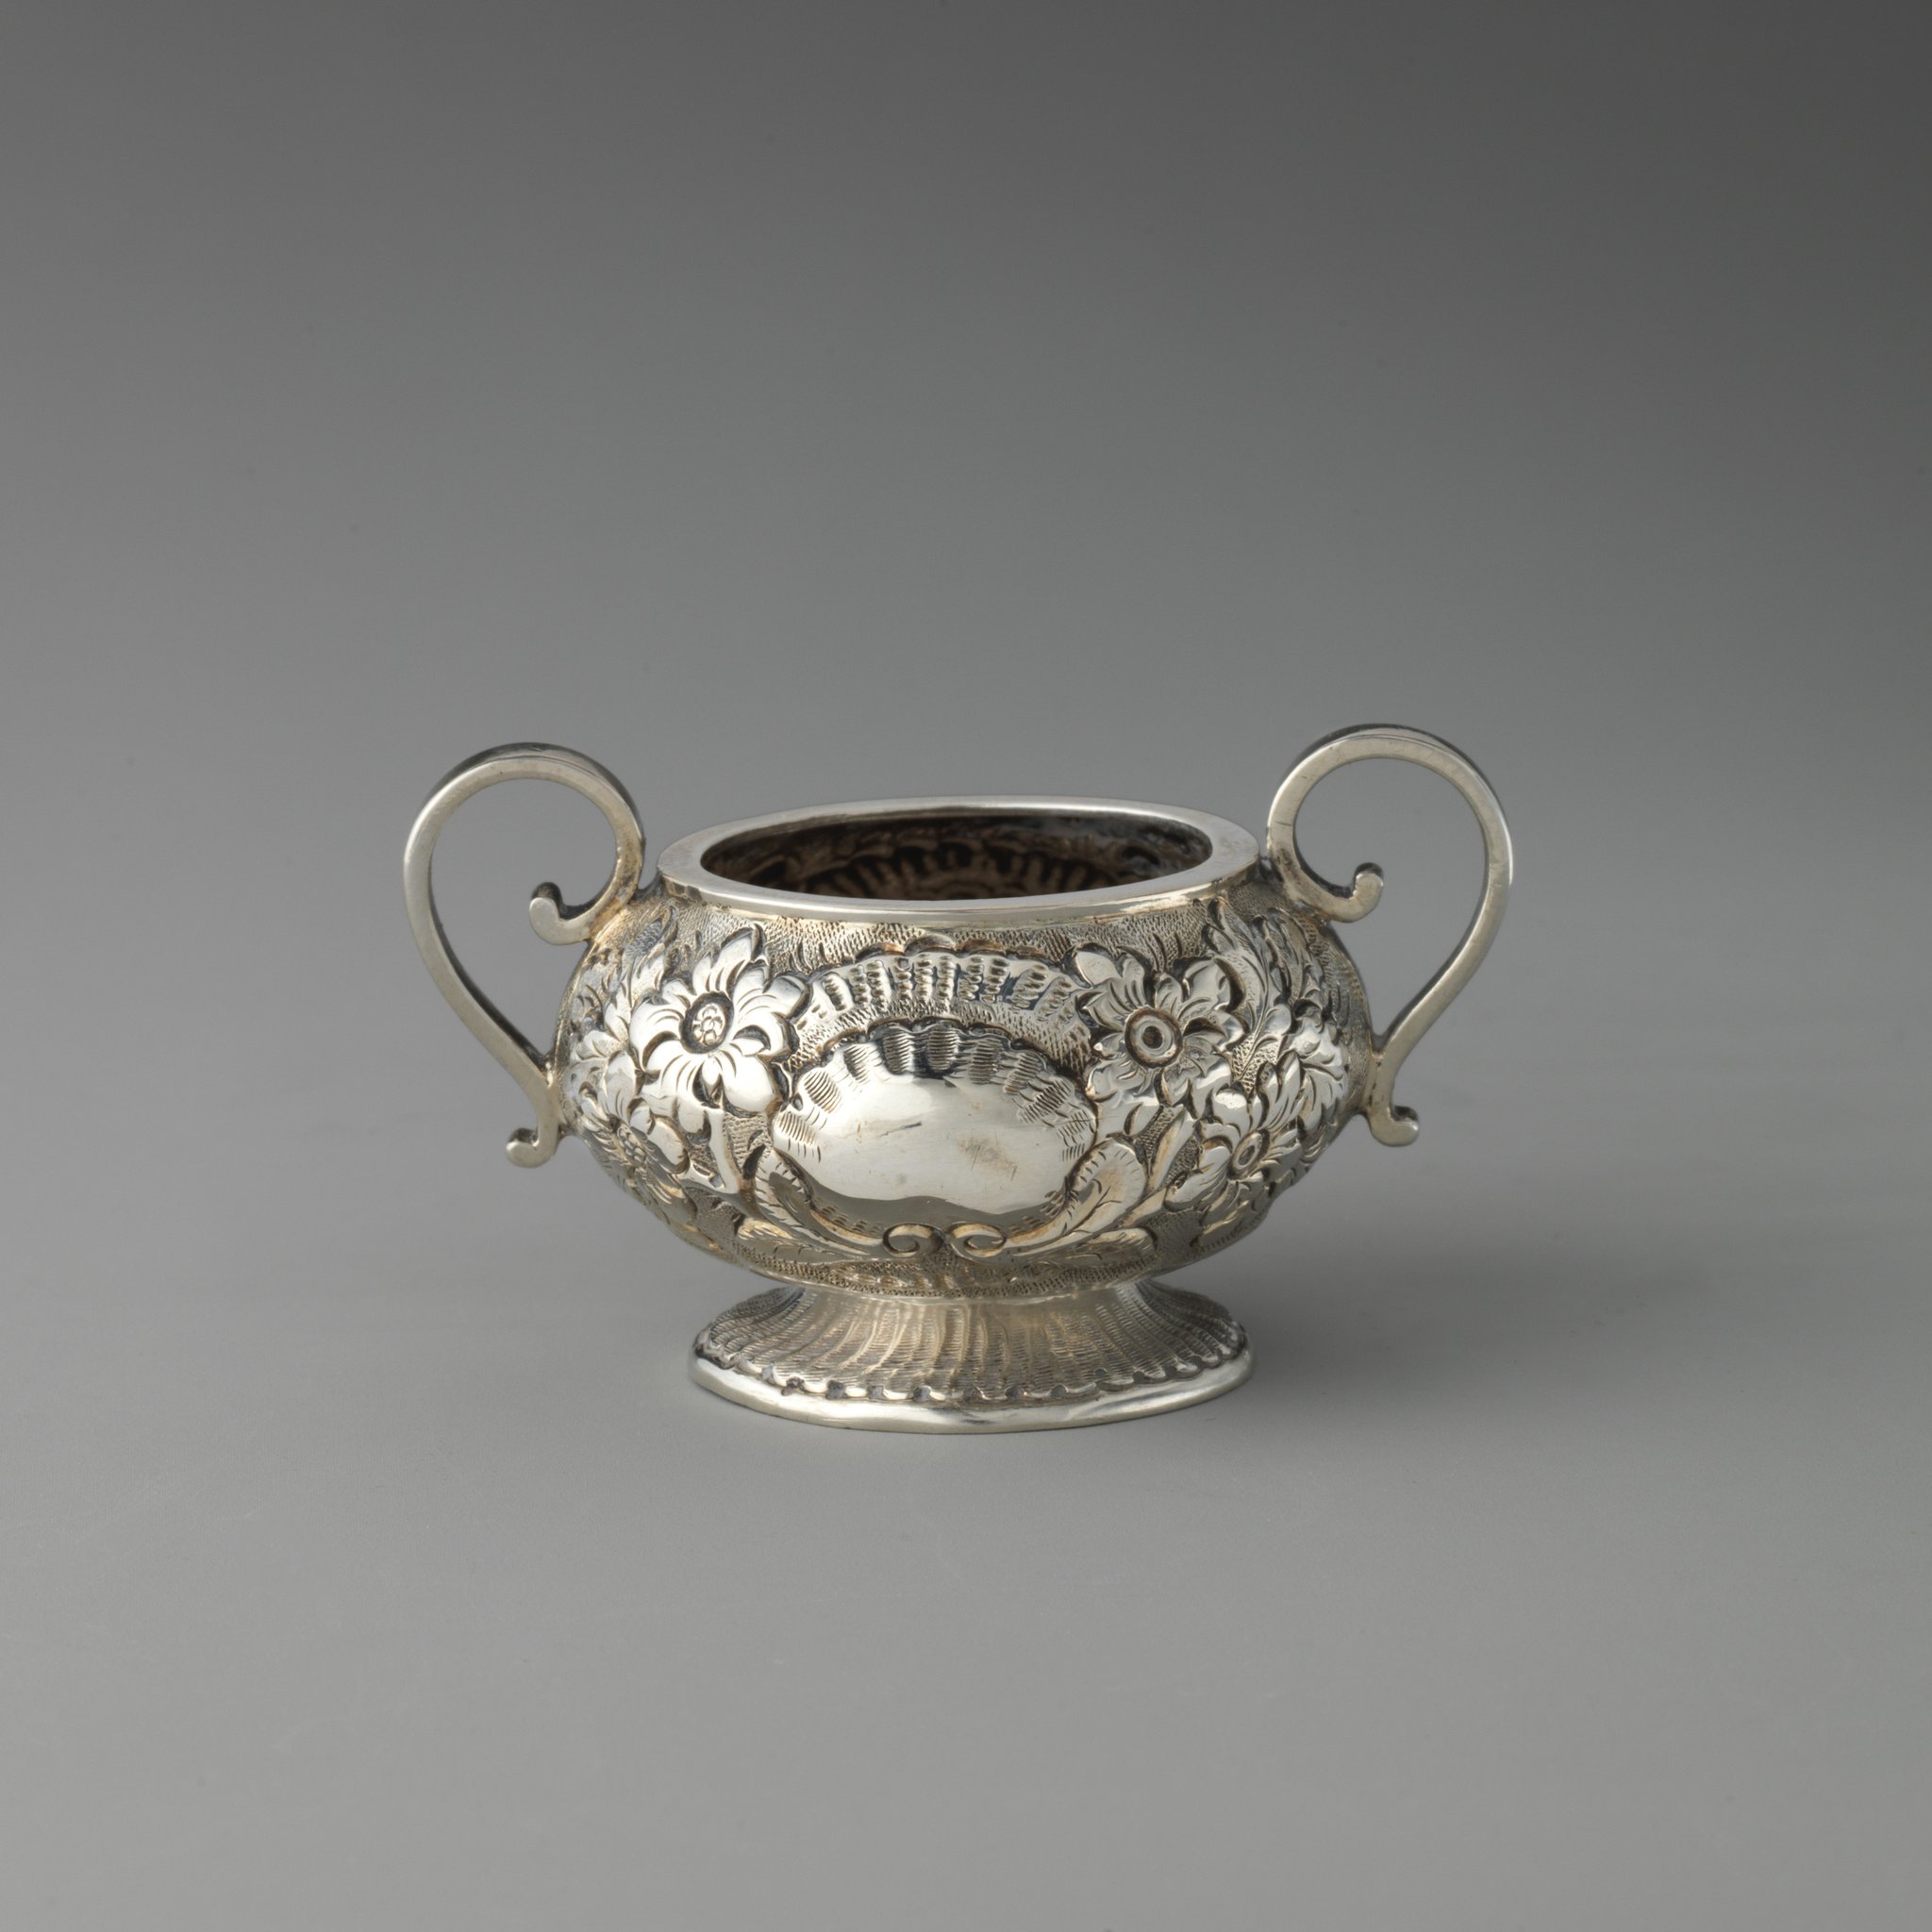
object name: sugar bowl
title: Miniature sugar bowl (part of a set)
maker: henry flavelle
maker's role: artist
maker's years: 1750-1850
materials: silver